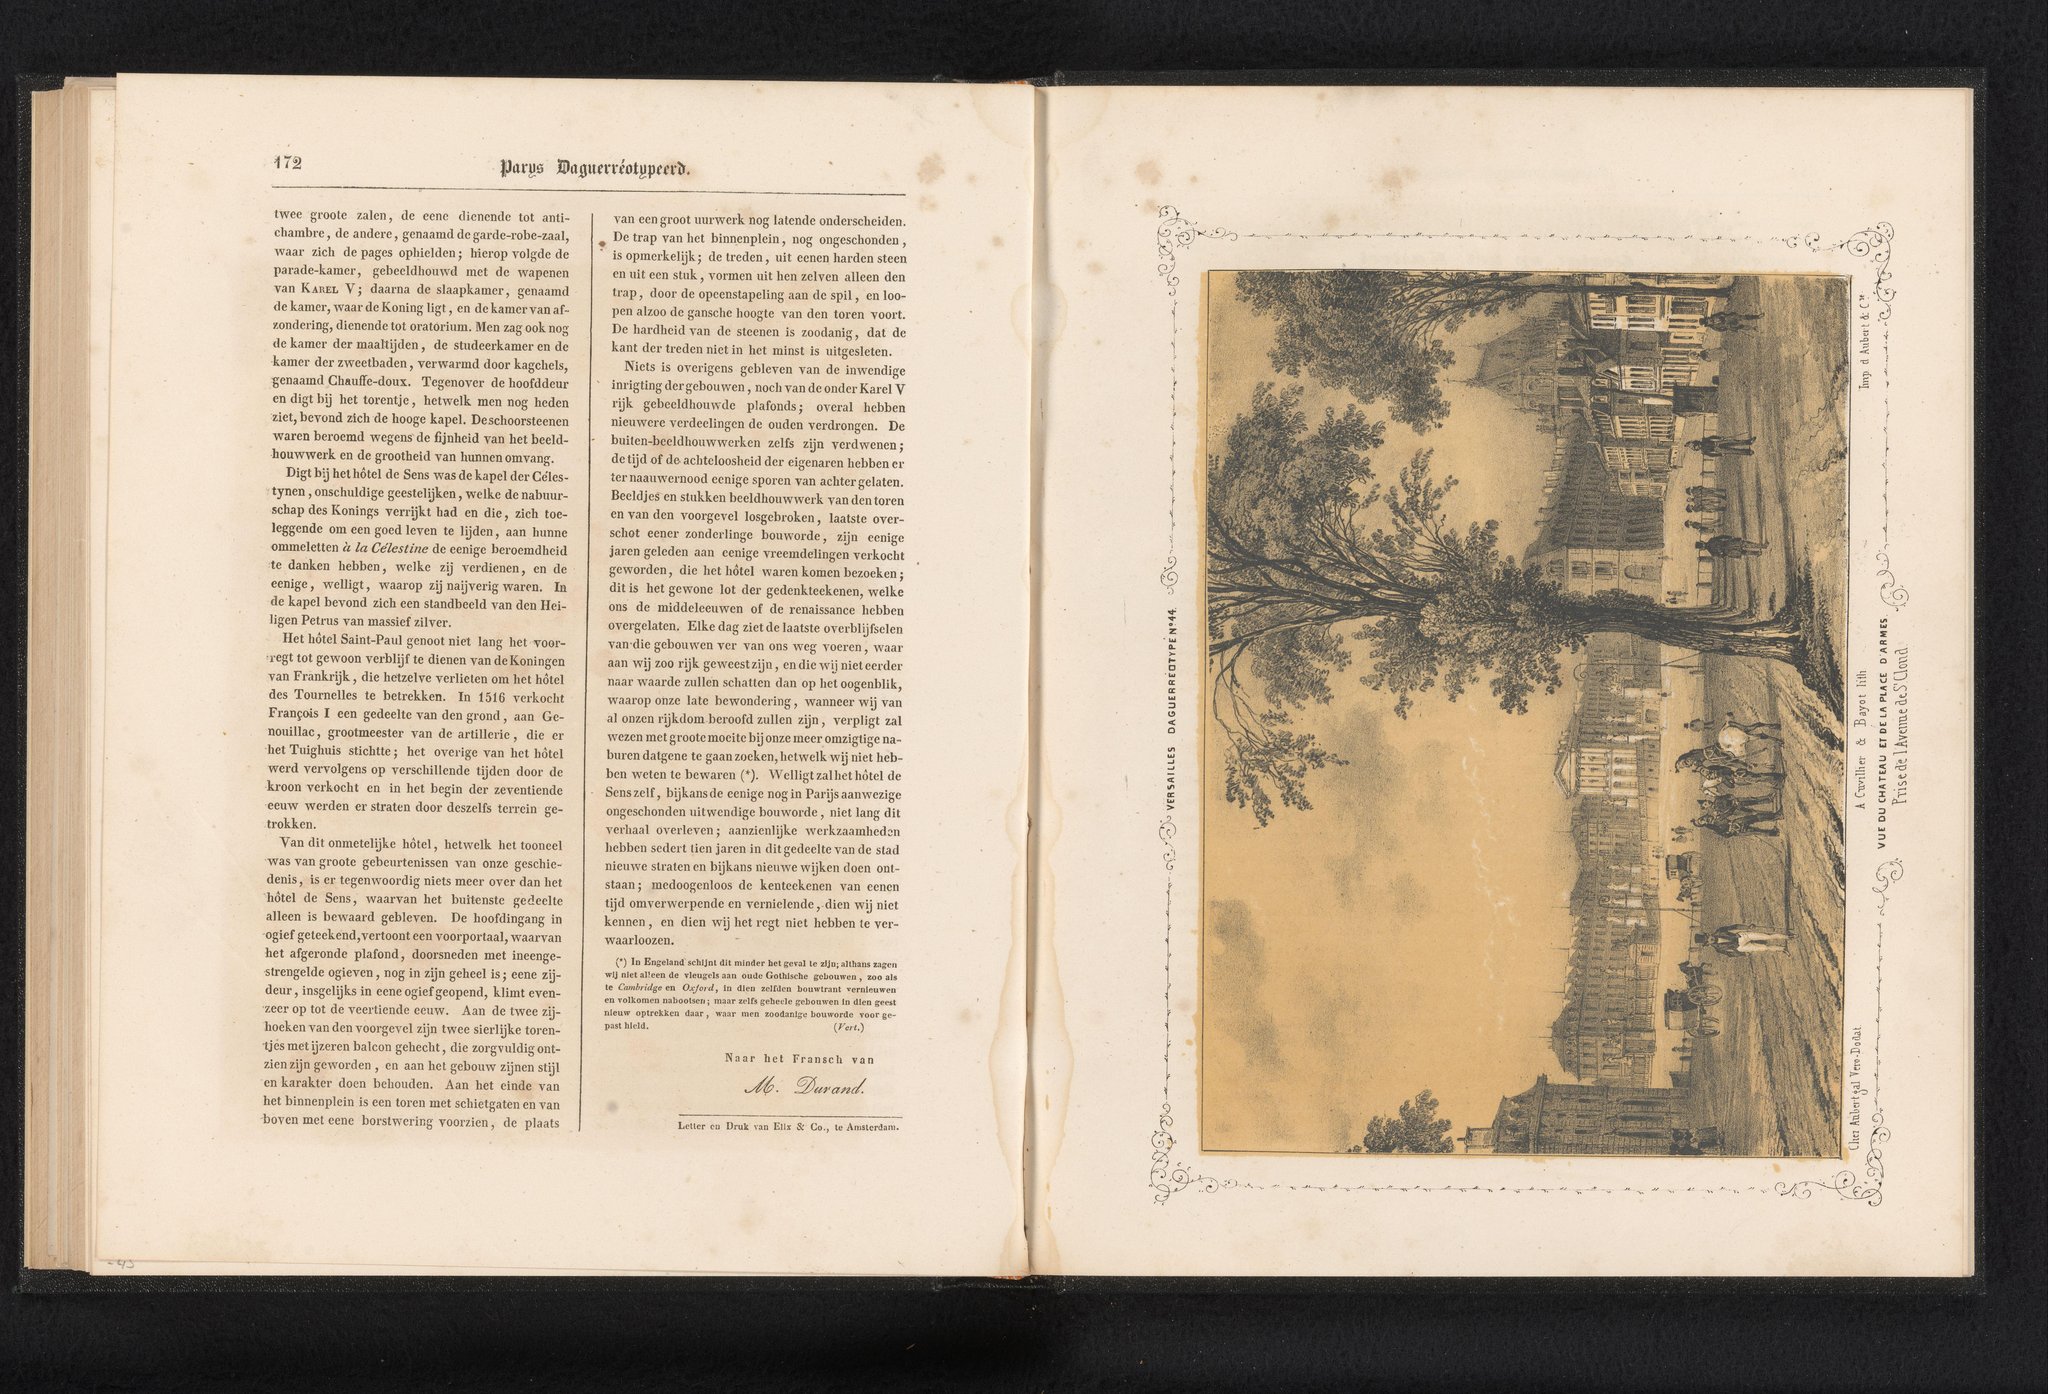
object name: print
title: Place d'Armes in Versailles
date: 1839-1840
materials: paper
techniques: tone lithography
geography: paris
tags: square, place, circus, etc.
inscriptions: inscription: ‘VERSAILLES DAGUERRÉOTYPÉ No. 44.’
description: Prent op honderdvijfenzeventigste ongenummerde pagina.